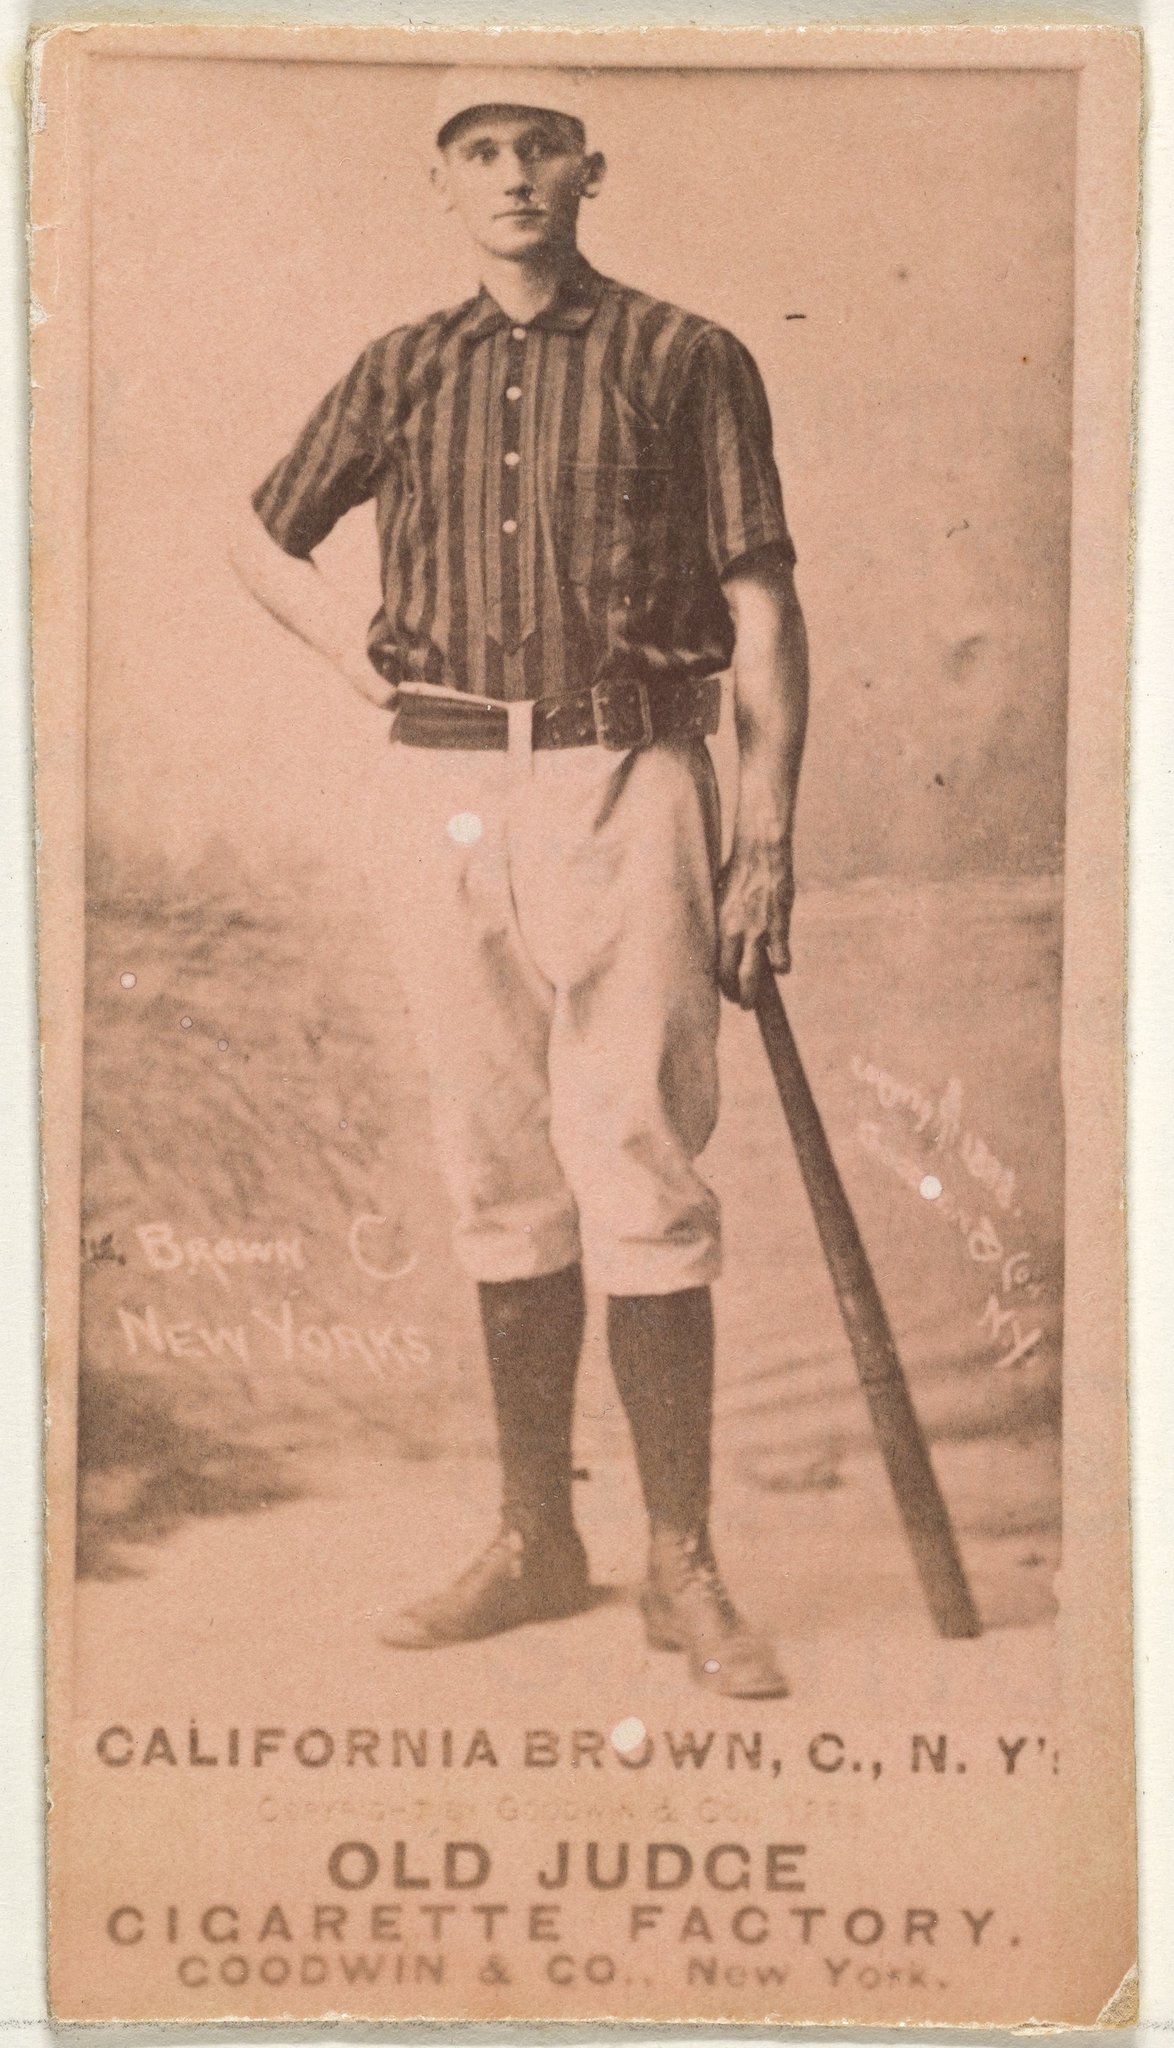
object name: baseball card, photograph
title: William "California" Brown, Catcher, New York, from the Old Judge series (N172) for Old Judge Cigarettes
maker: goodwin & company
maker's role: publisher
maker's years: 1850-1950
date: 1888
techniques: albumen silver print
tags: men,portraits,baseball,athletes